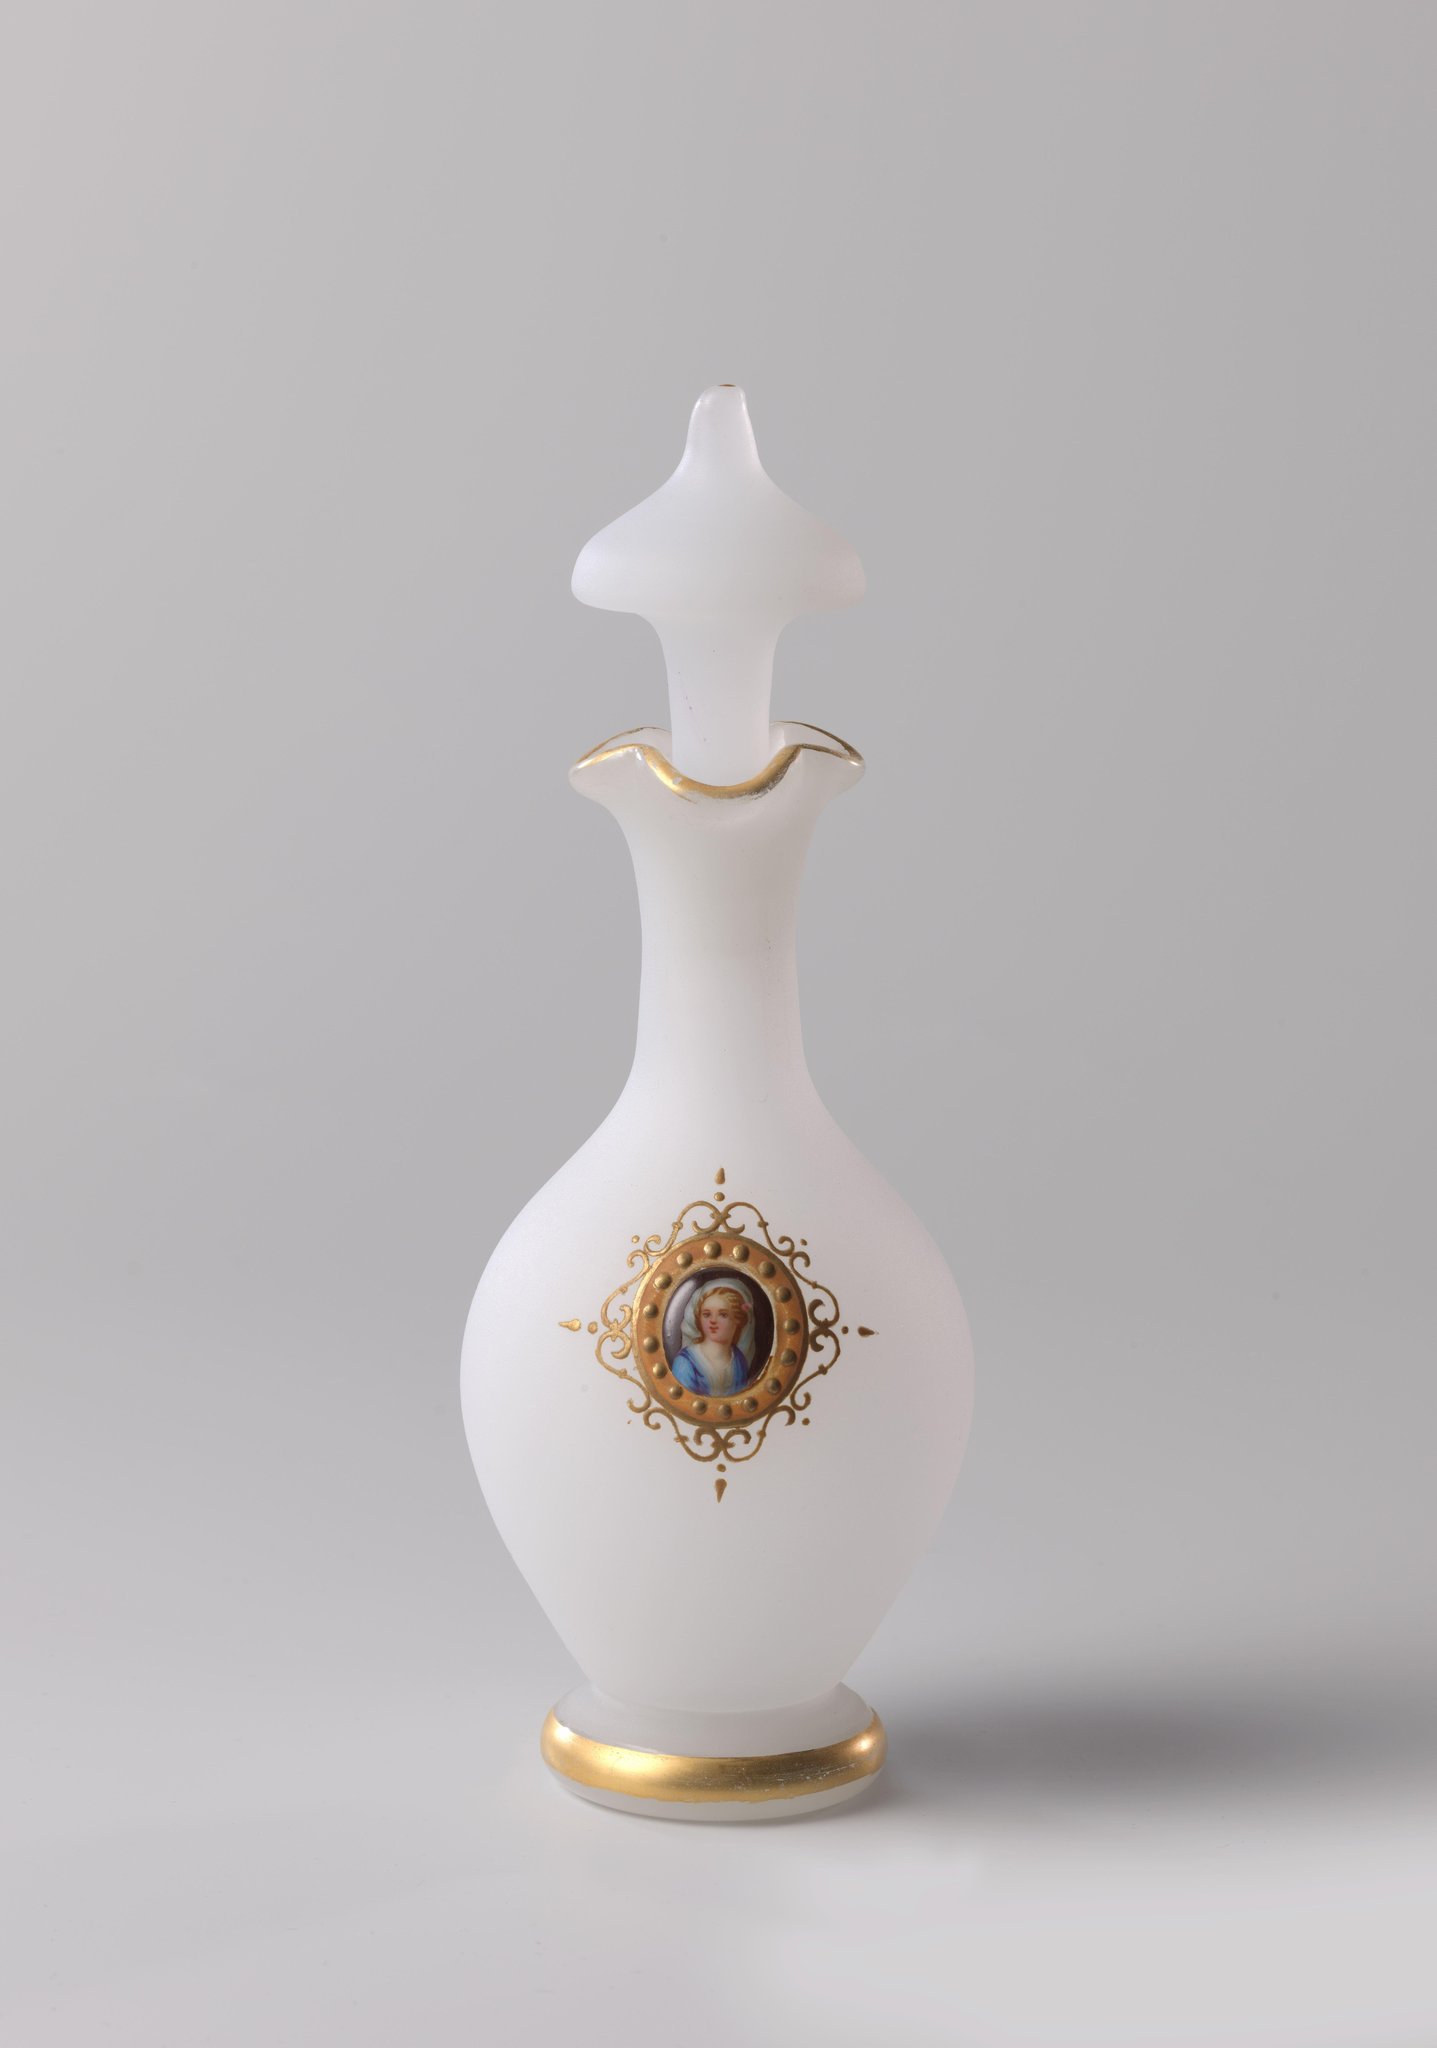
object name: carafe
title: Karaf met een medaillon met een vrouwenportret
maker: Anonymous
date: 1850-1900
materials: glass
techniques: gilding, glassblowing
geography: france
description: Vlakke bodem. Lage voet, eivormig lichaam, overgaande in een rechte hals met een in een vierpas uitgebogen mond. Op het lichaam een ovaal medaillon met een vrouwenportret in een vergulde rand van voluten en stippen. Mondrand en rand van de voet verguld.